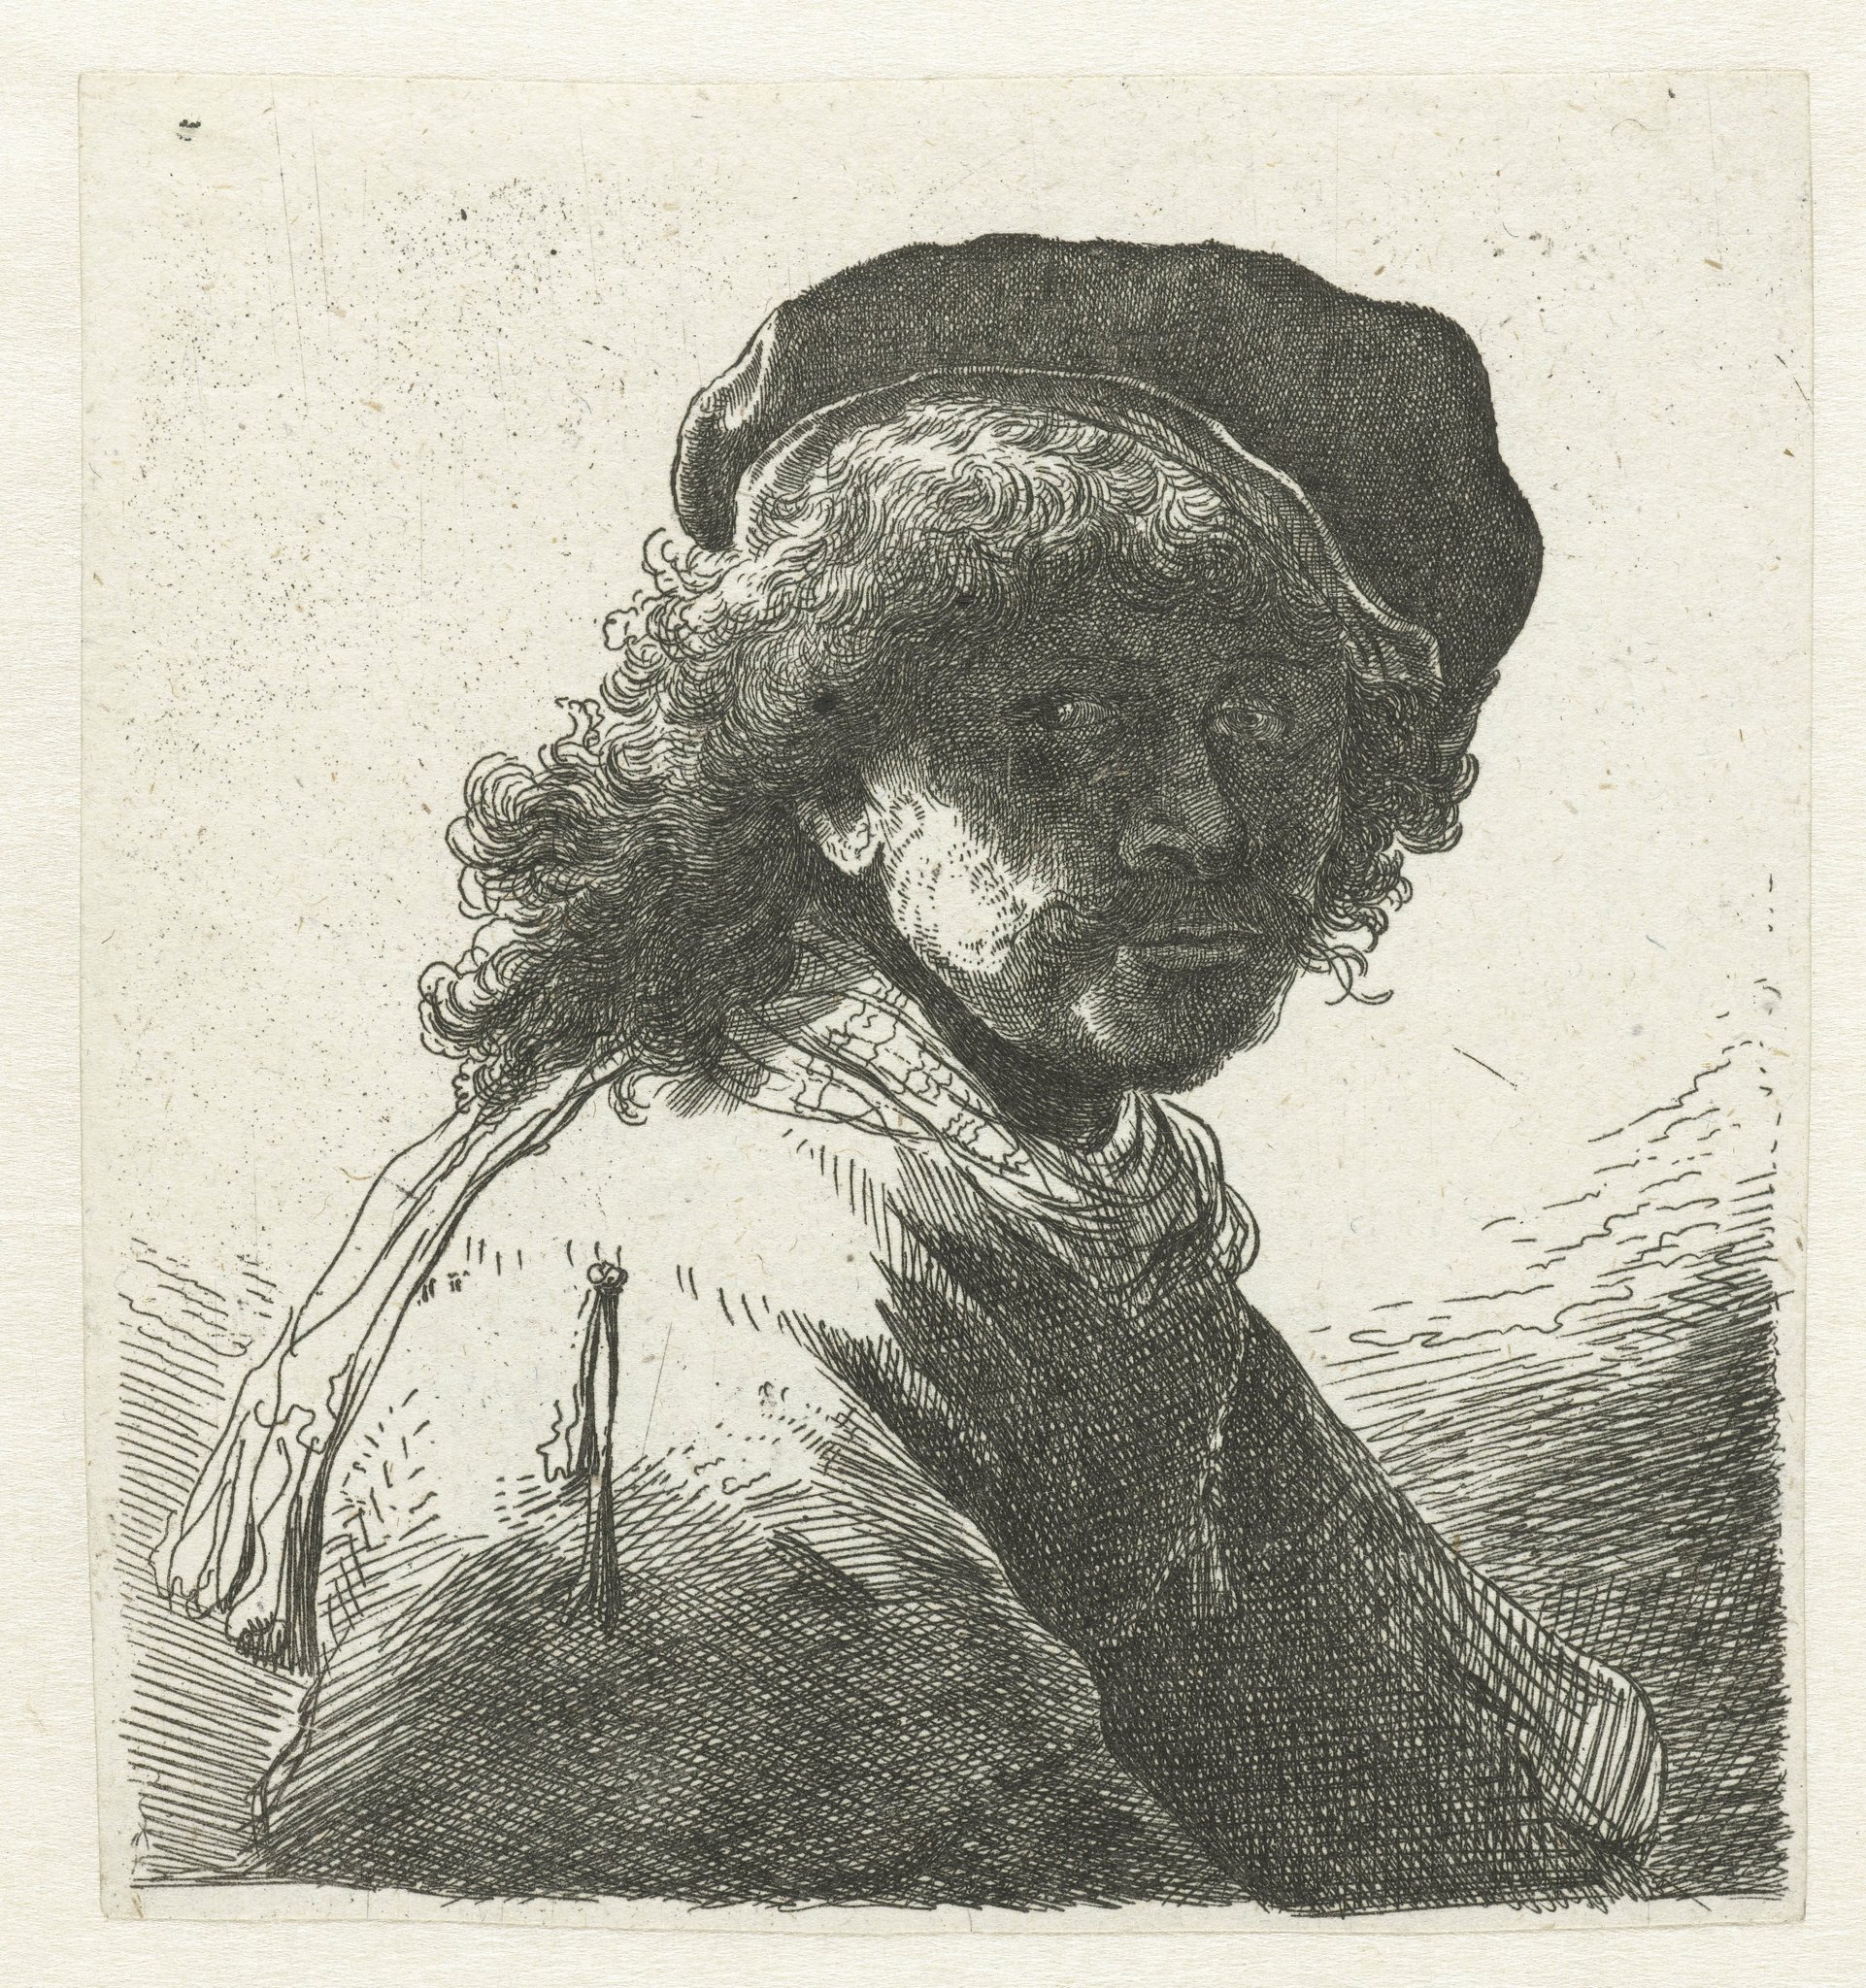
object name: print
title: Self-portrait in a cap and scarf with the face dark: bust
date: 1711-1800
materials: paper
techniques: etching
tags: leiden, amsterdam, painter, print maker, draughtsman, rembrandt van rijn, portrait, self-portrait of graphic artist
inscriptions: collector's mark: Lugt 2228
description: Spiegelbeeldige kopie naar de gelijknamige prent van Rembrandt.